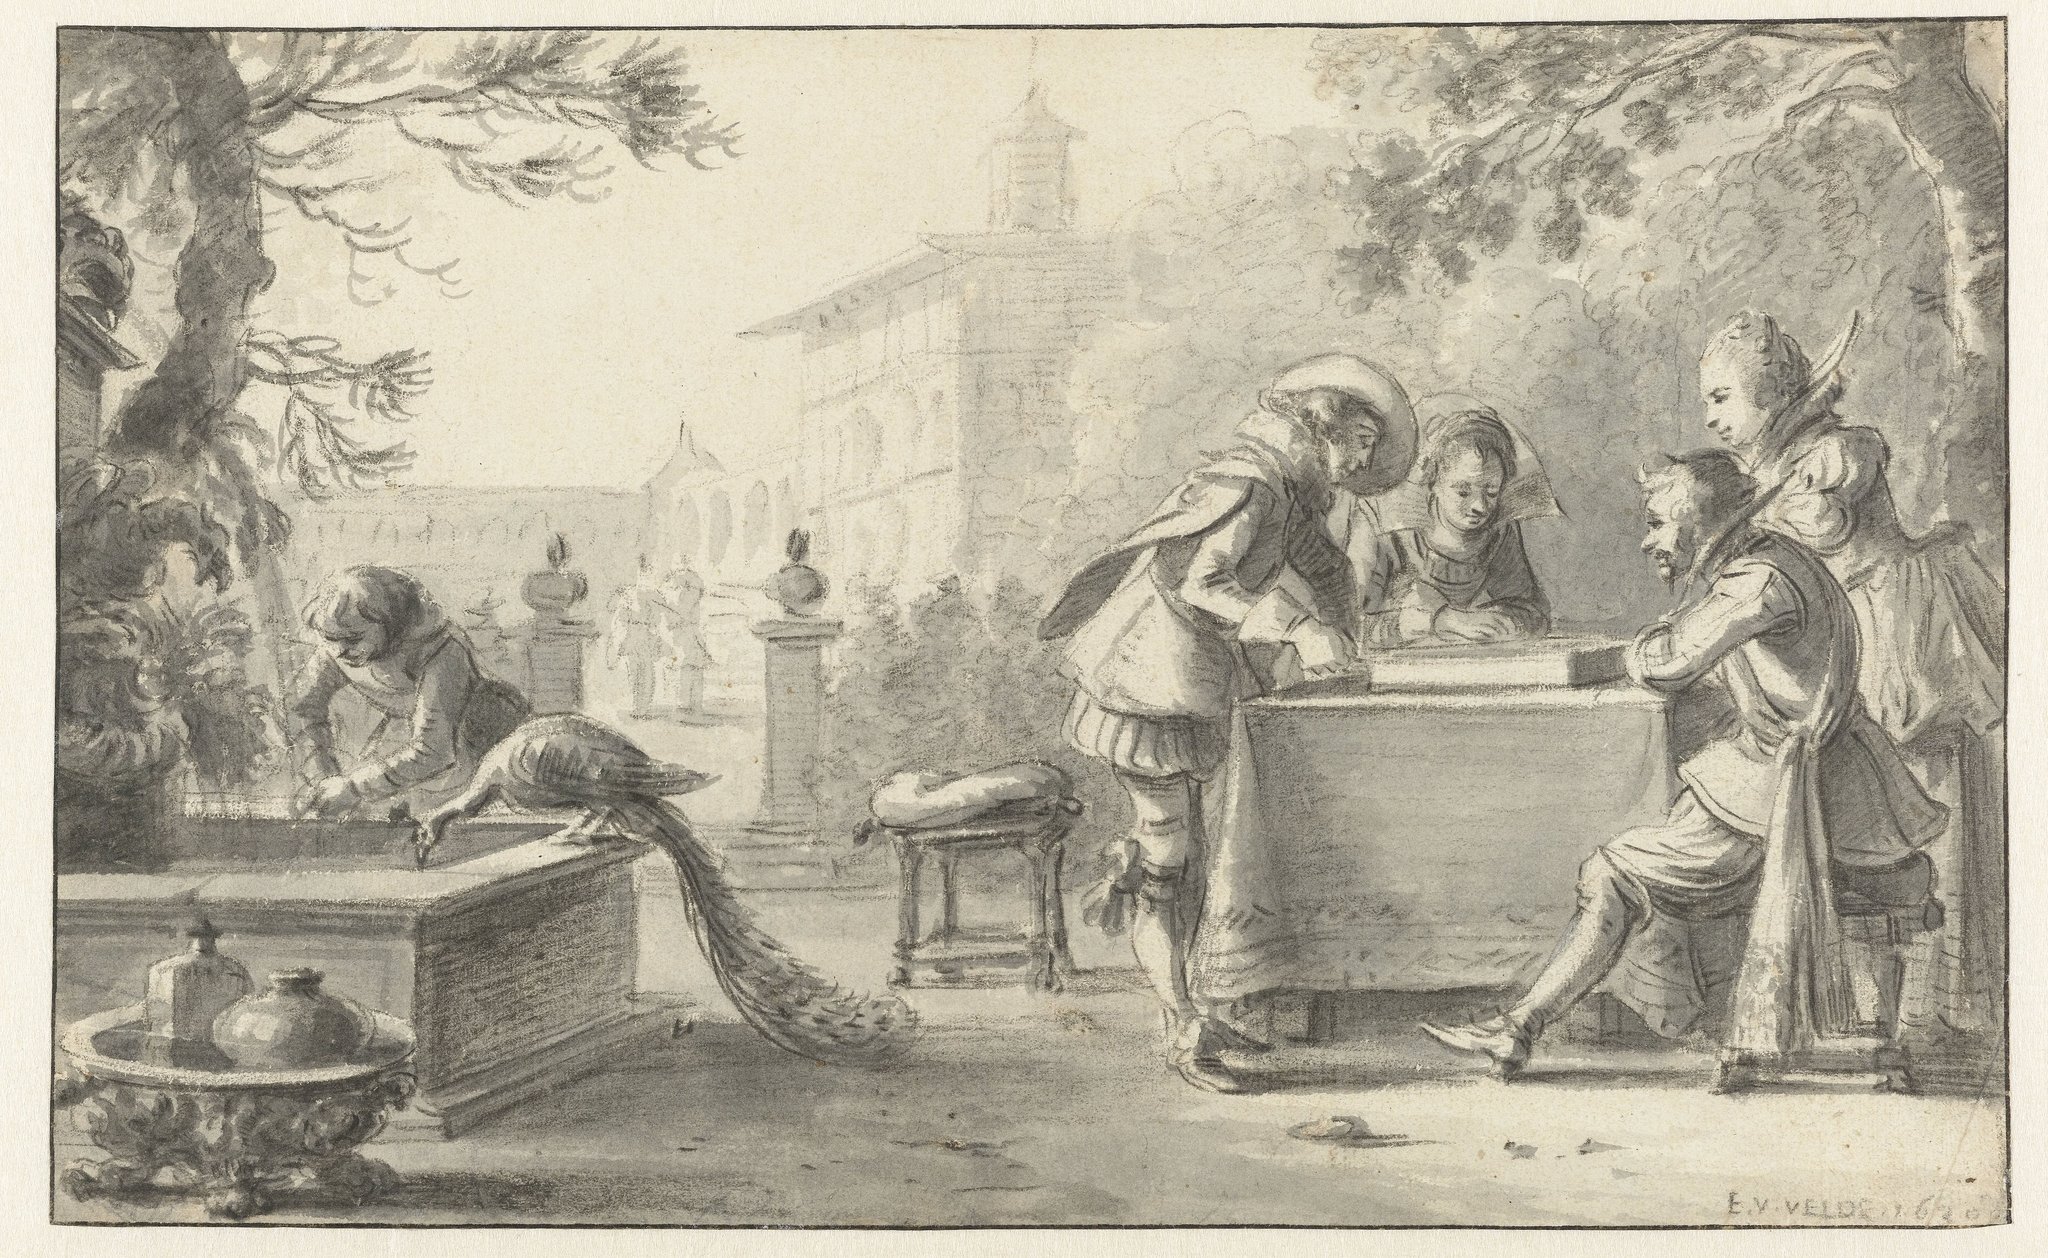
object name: drawing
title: Tric-trac Players in a Castle Garden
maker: esaias van de velde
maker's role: draughtsman, painter, print maker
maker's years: 1587-1630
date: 1630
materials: chalk, paper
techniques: brush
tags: coat (+ men's clothes), visiting; receiving guests; elegant company, garden, garden fountain, head-gear: hat (+ men's clothes), ornamental birds: peacock, backgammon, tric-trac, wine-cooler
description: Esaias van de Velde made various depictions of merry companies in a garden. This is the only one with tric-trac players. This game was once considered to be gambling. This negative association is here enhanced by the jugs of alcohol in the foreground and the amorous couples. Just as in modern portrayals of casinos, such as in James Bond films, the women encourage the men immersed in the game.